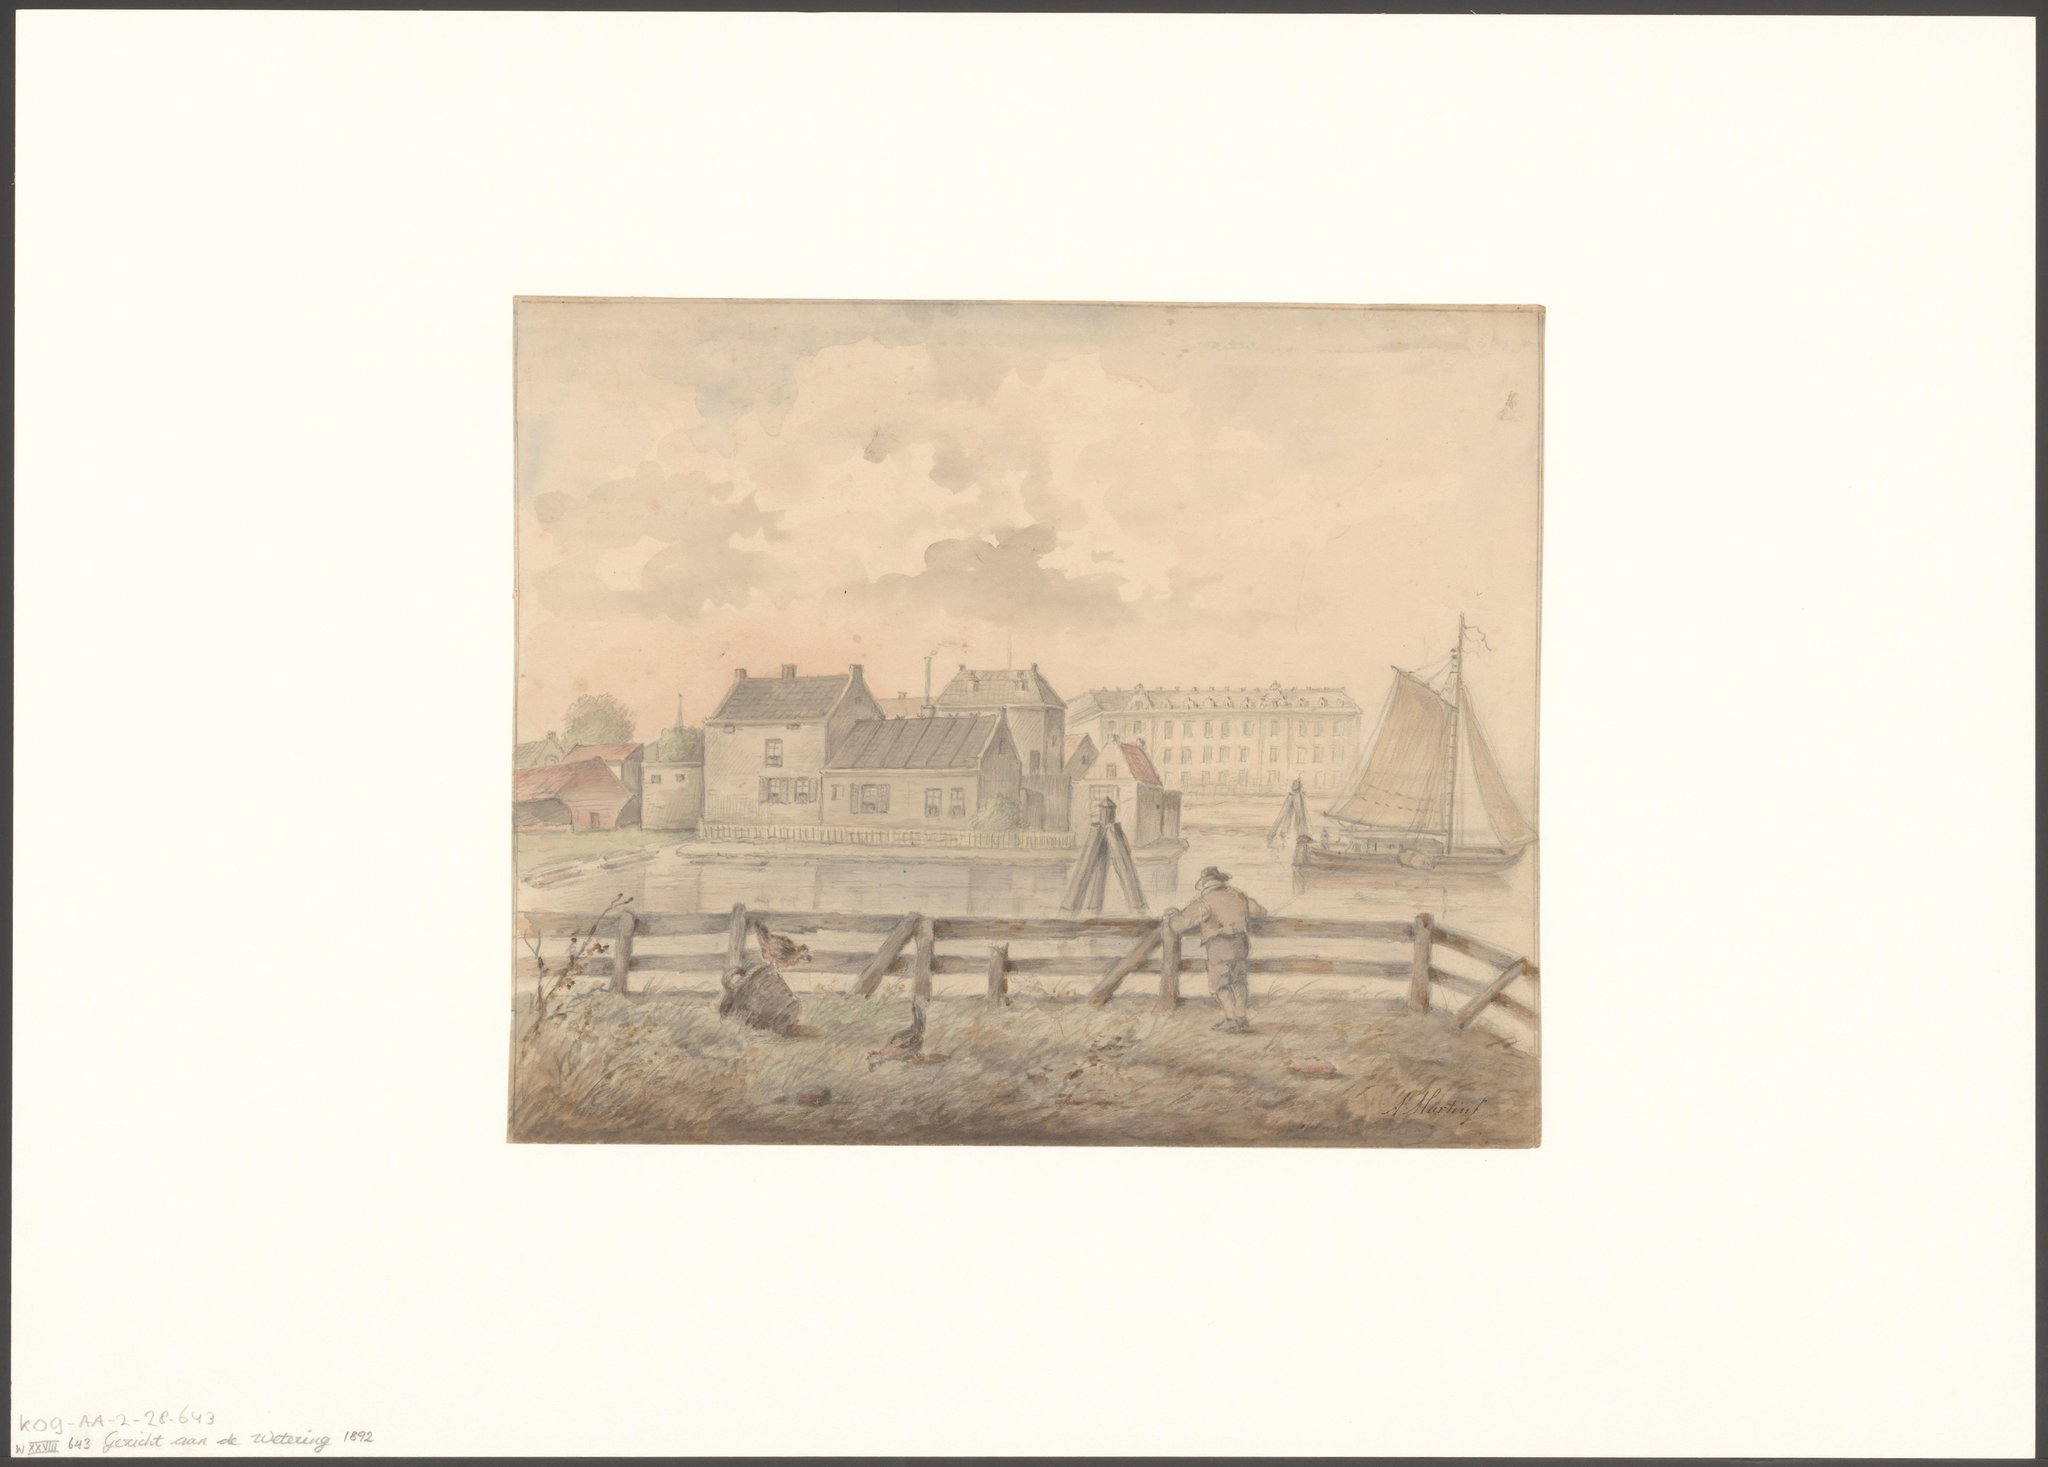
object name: drawing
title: Gezicht op de Kostverlorenvaart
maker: albert martin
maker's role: draughtsman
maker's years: 1827-1900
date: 1837-1900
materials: paper, pencil, watercolor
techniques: brush, pen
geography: amsterdam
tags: sailing-ship, sailing-boat, city-view in general; 'veduta', canal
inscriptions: signature: ‘A.Martin f’, collector's mark: Lugt 800a, inscription: ‘Gezicht aan de Wetering’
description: Tekening binnen de Atlas Van Eck ingedeeld op wijknummer 28.